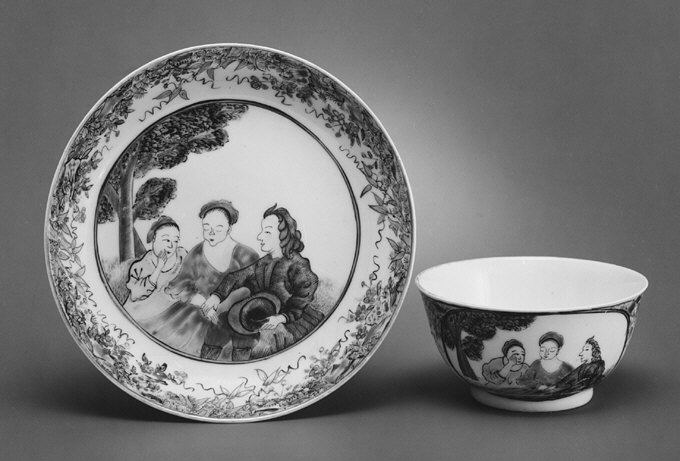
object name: teabowl and saucer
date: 1770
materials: hard paste porcelain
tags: women,trees